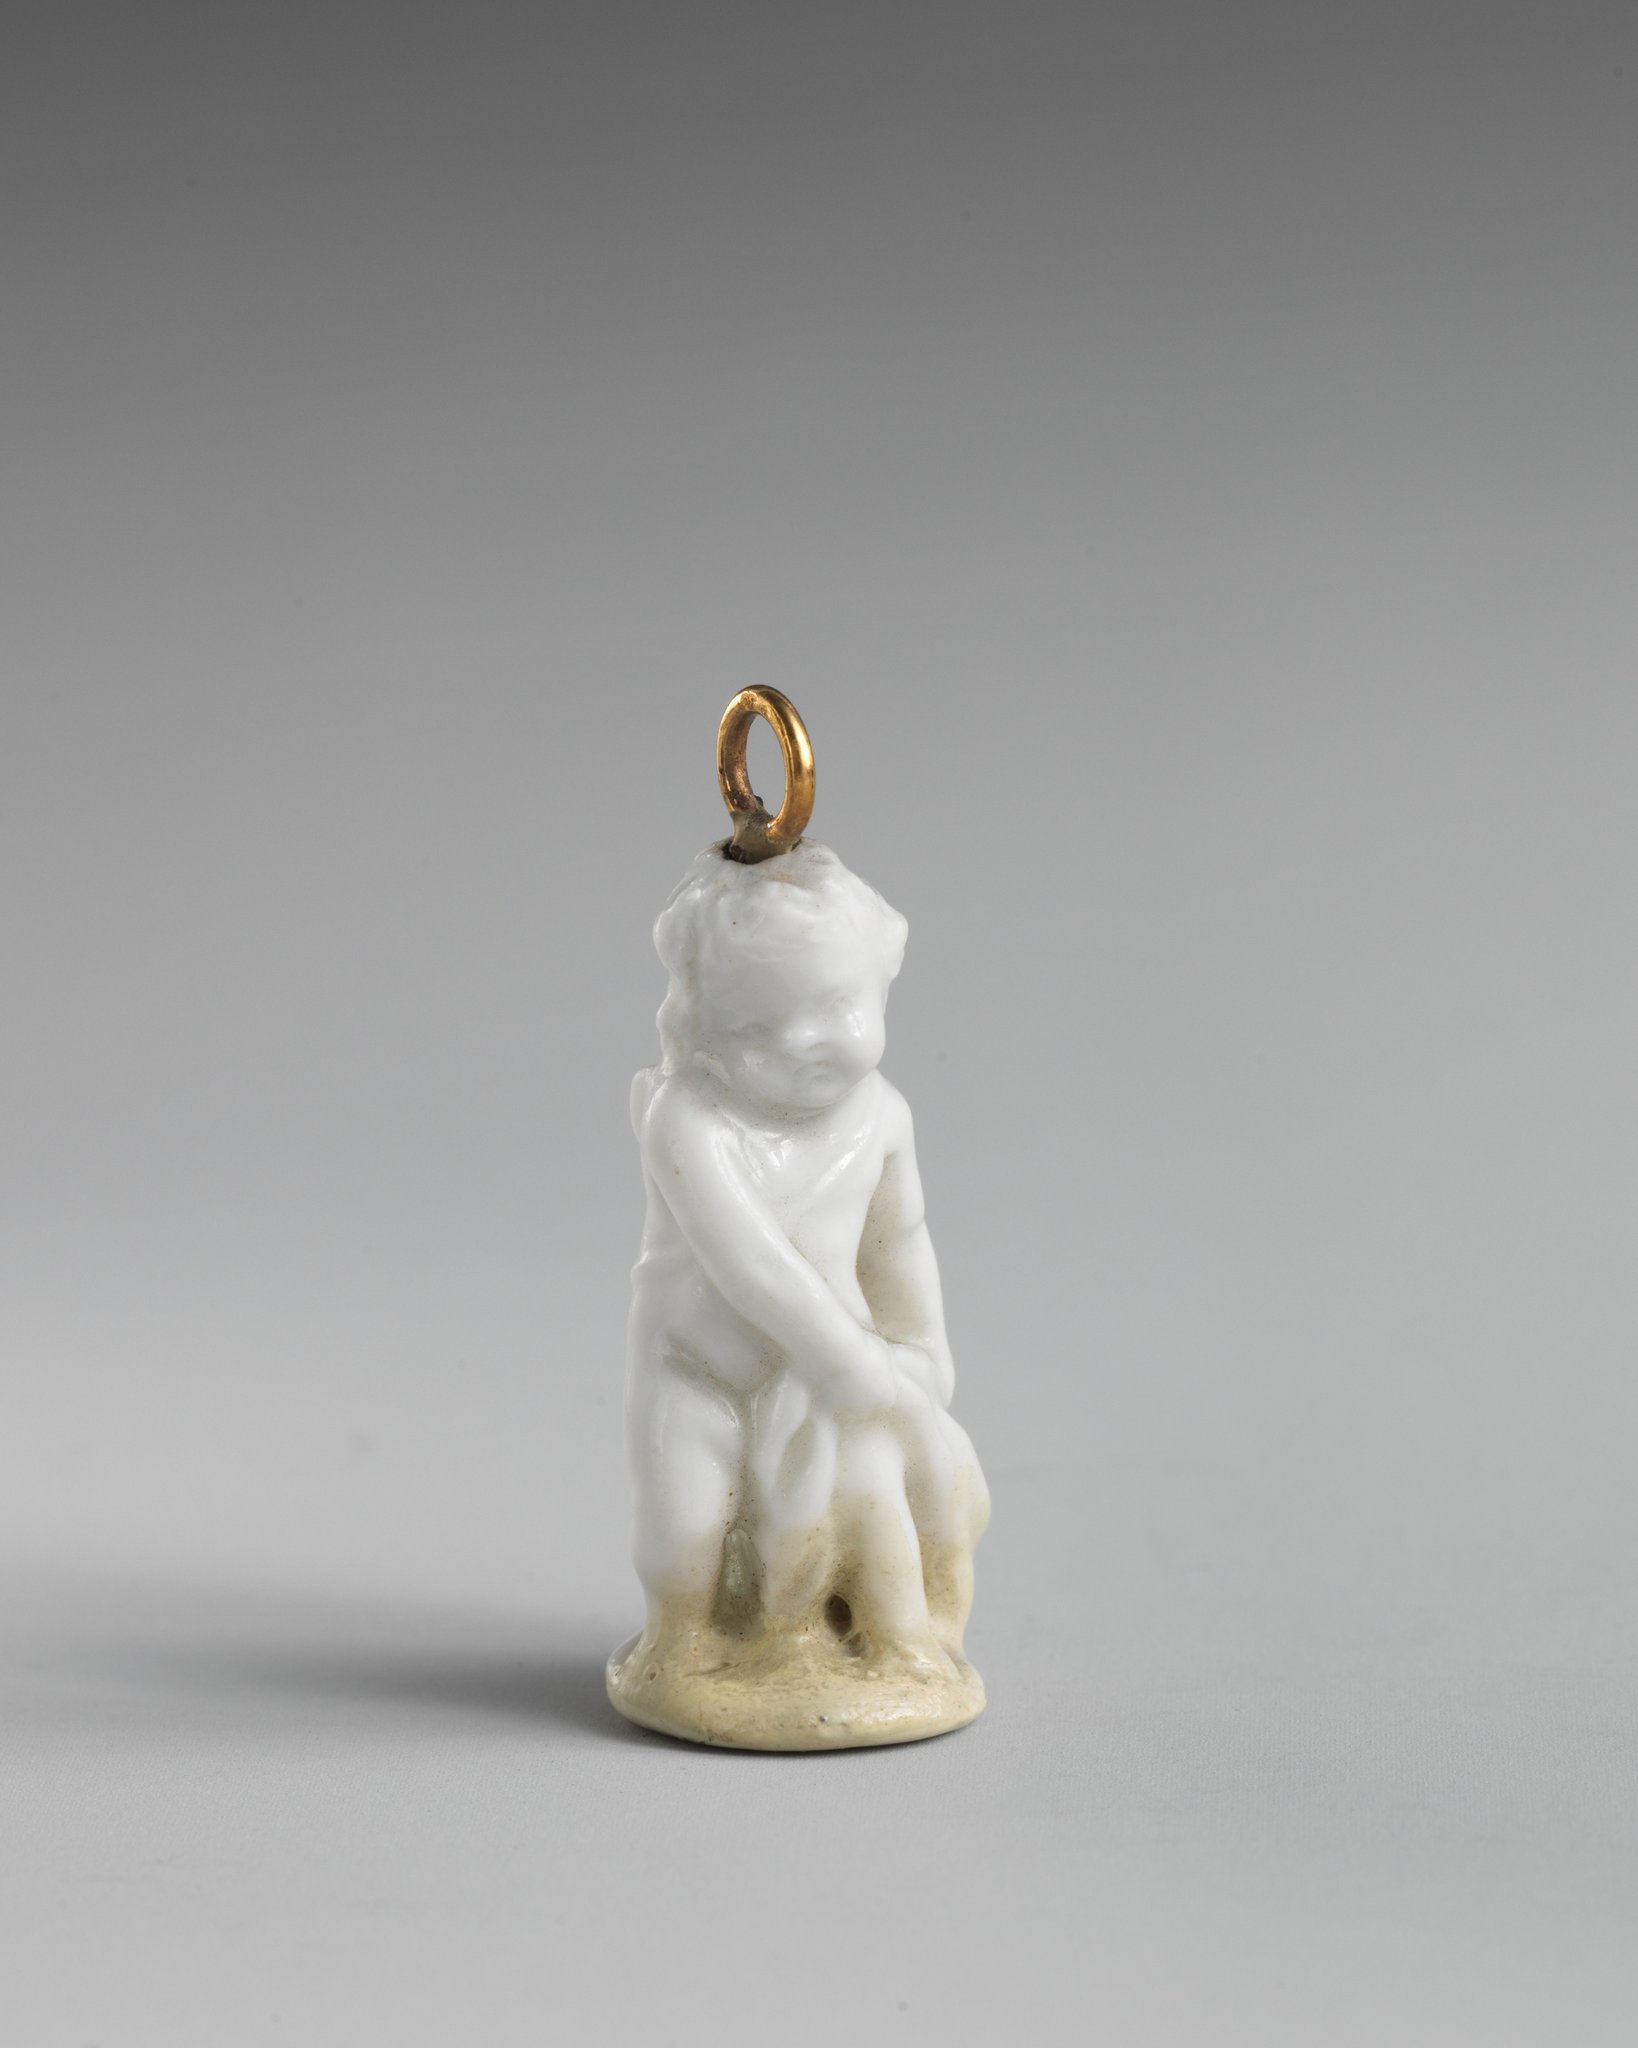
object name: seal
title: Miniature seal in the form of Cupid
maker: chelsea porcelain manufactory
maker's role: factory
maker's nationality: british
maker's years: 1744-1784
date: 1753-1758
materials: gilt copper, soft paste porcelain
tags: cupid